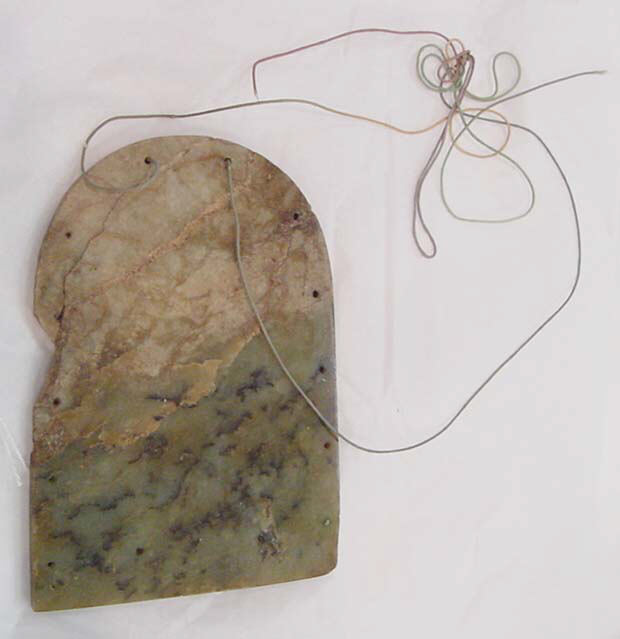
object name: pendant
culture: chinese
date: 206 BCE-220 CE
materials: cotton, jade